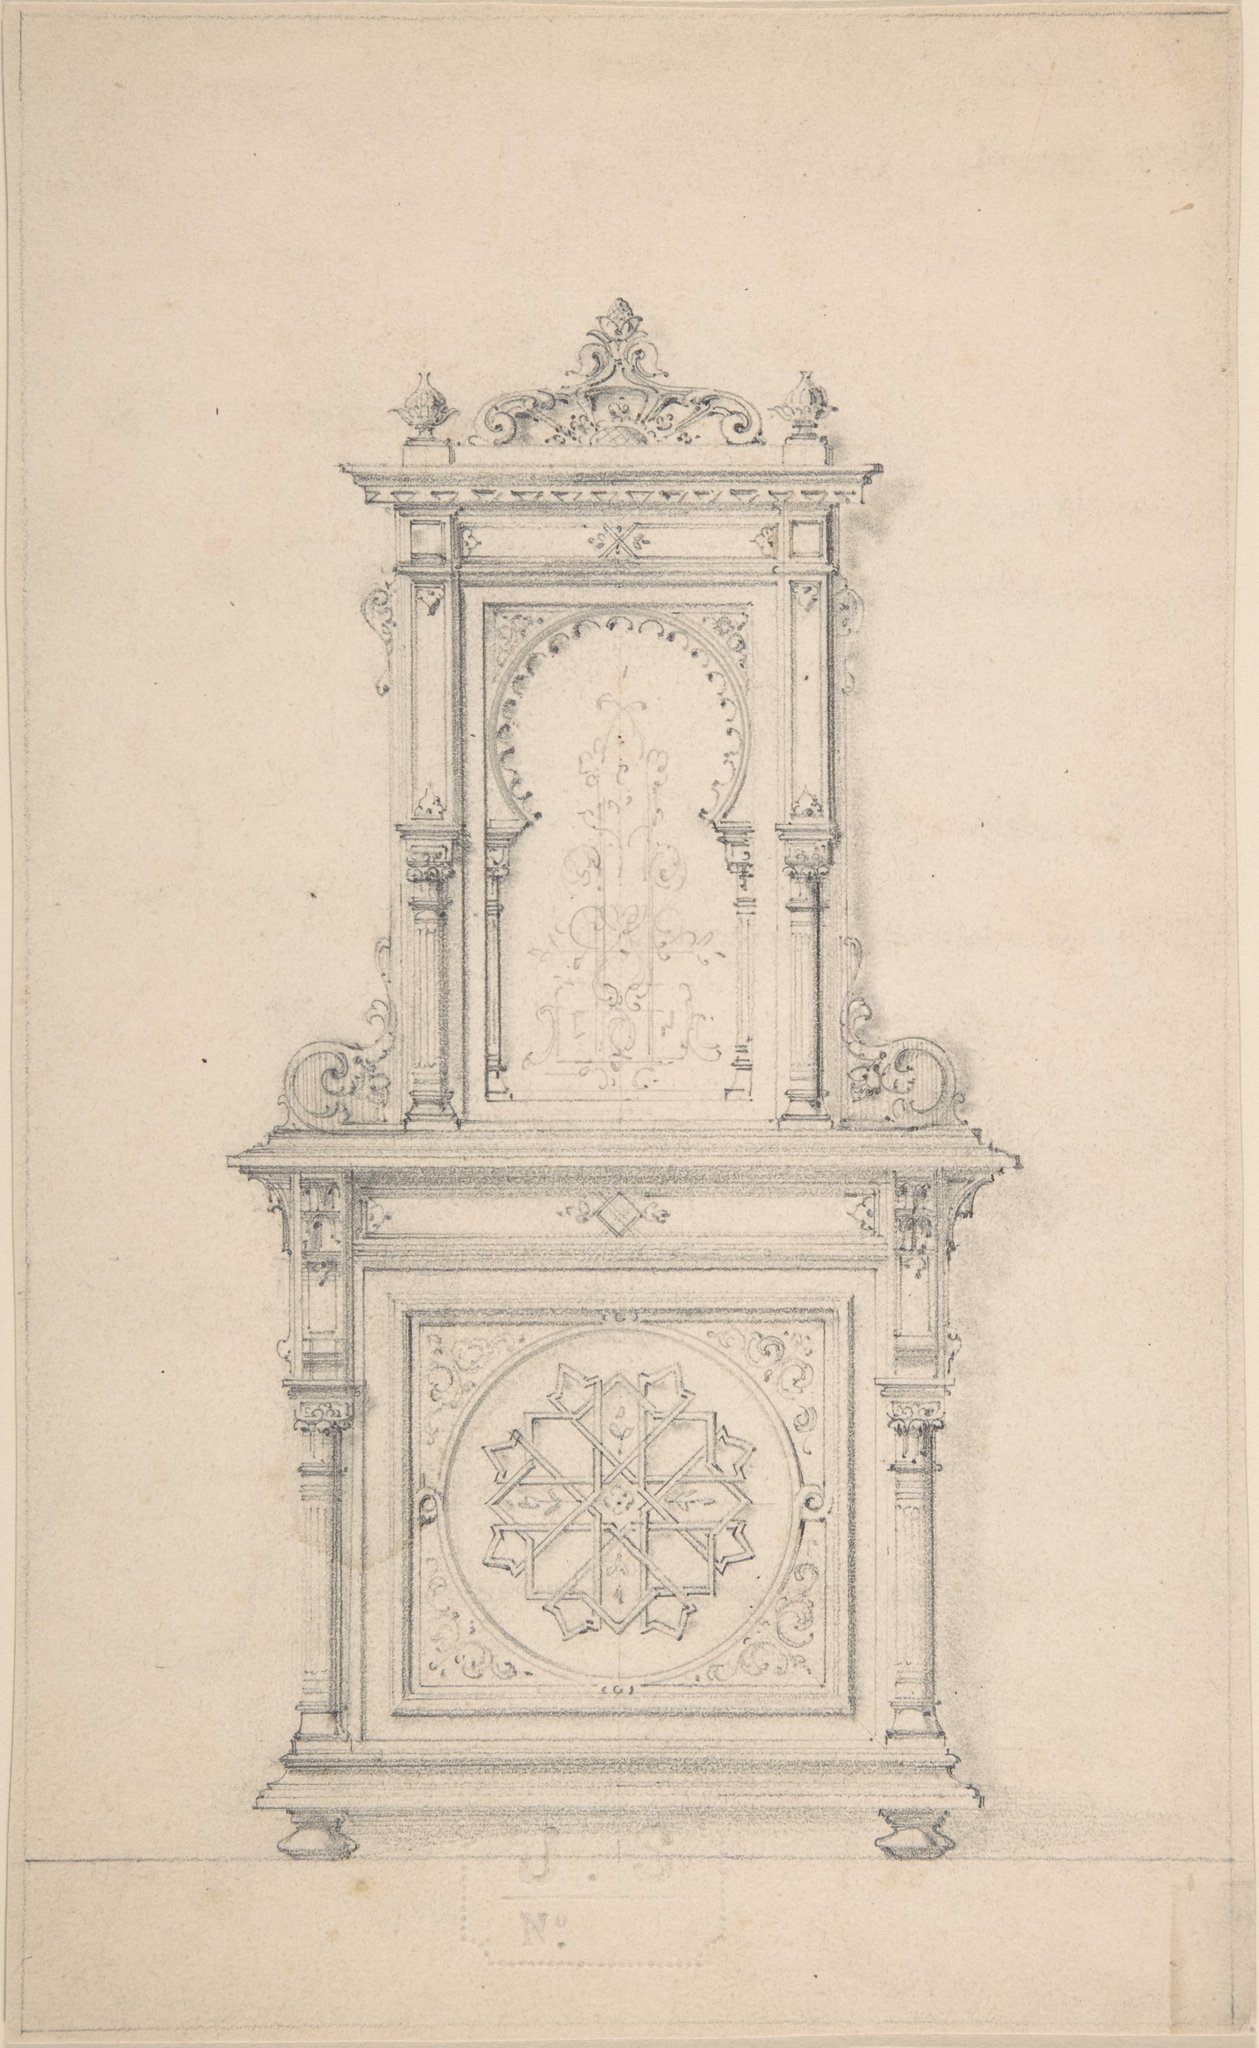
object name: drawing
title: Design for a Cabinet in Moorish Style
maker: anonymous, french, 19th century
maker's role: artist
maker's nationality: french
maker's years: 1800-1900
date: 1801-1900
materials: graphite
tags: cabinets